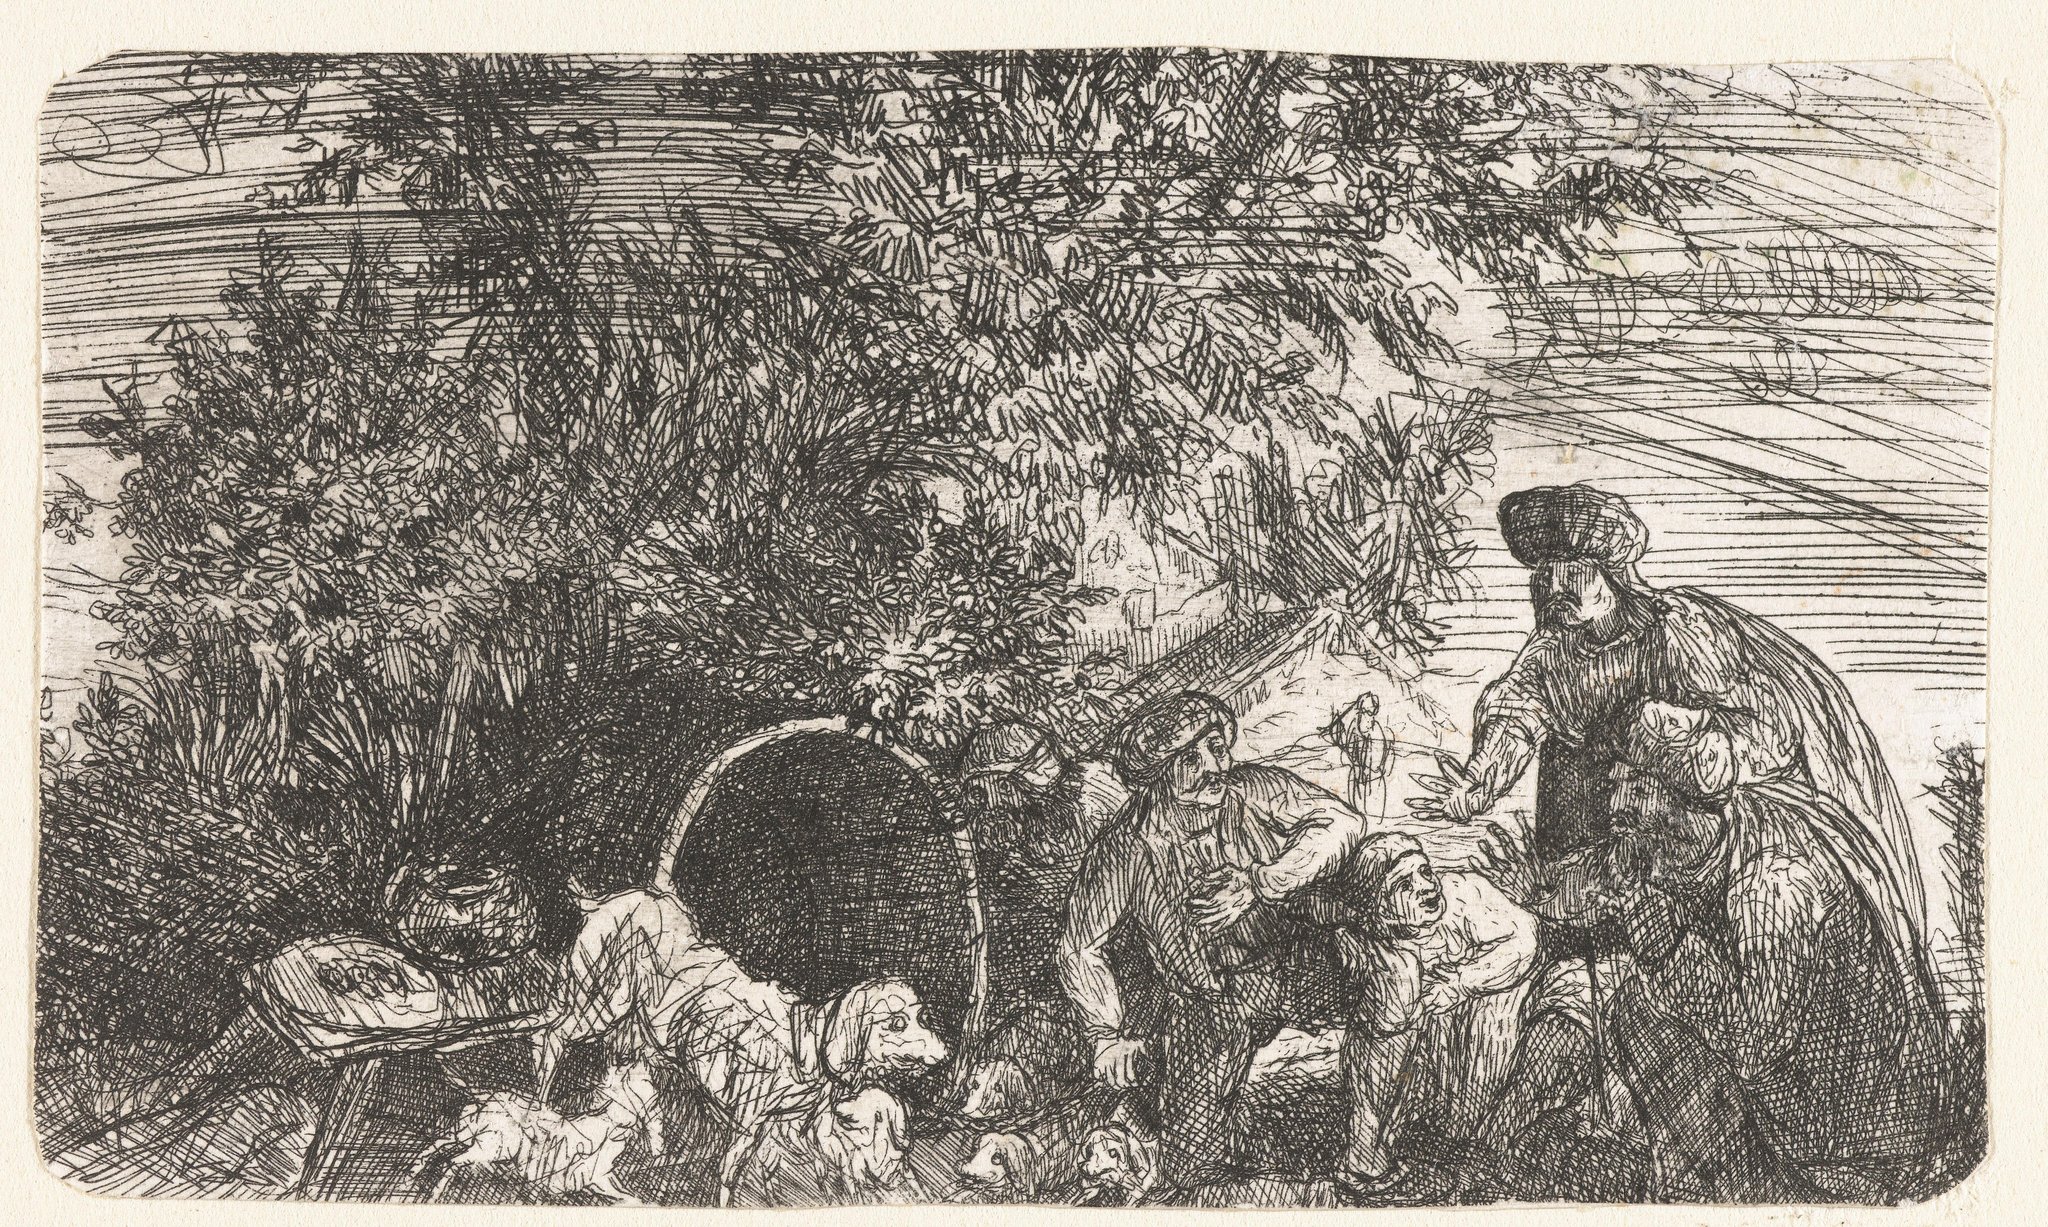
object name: print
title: Scène orientale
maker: rodolphe bresdin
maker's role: draughtsman, print maker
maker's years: 1822-1885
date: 1844-1849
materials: paper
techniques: etching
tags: man and animal (+ young animal), dog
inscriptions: collector's mark: Lugt 2228, inscription: ‘Acheté de Paul Bresdin/ 6 Mai 1929 P. et R. Nice’, collector's mark: Lugt 2760, collector's mark, collector's mark: Lugt 2069a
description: Drie mannen en een kind knielen en staan bij een ton onder een boom in het struikgewas en kijken naar een hond met een nest jongen. De twee mannen rechts zijn oosters gekleed in lange mantels en zij dragen een tulband op het hoofd. Uit de armgebaren blijkt dat ze in gesprek zijn met de boer. Achter deze figuur is de gevel van een boerderij met daarvoor een staande figuur schetsmatig weergegeven.